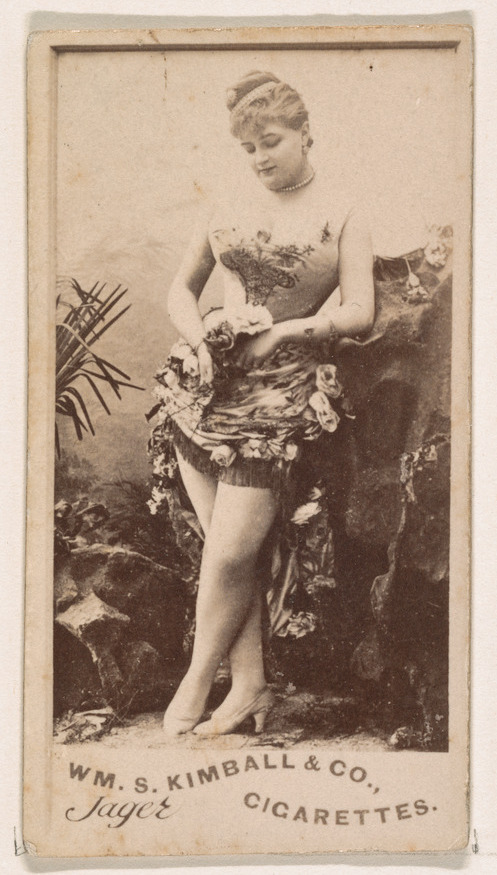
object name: photograph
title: Mlle. Jager, from the Actresses series (N203) issued by Wm. S. Kimball & Co.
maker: william s. kimball & company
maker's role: publisher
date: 1889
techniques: color lithograph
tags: portraits,women,actresses